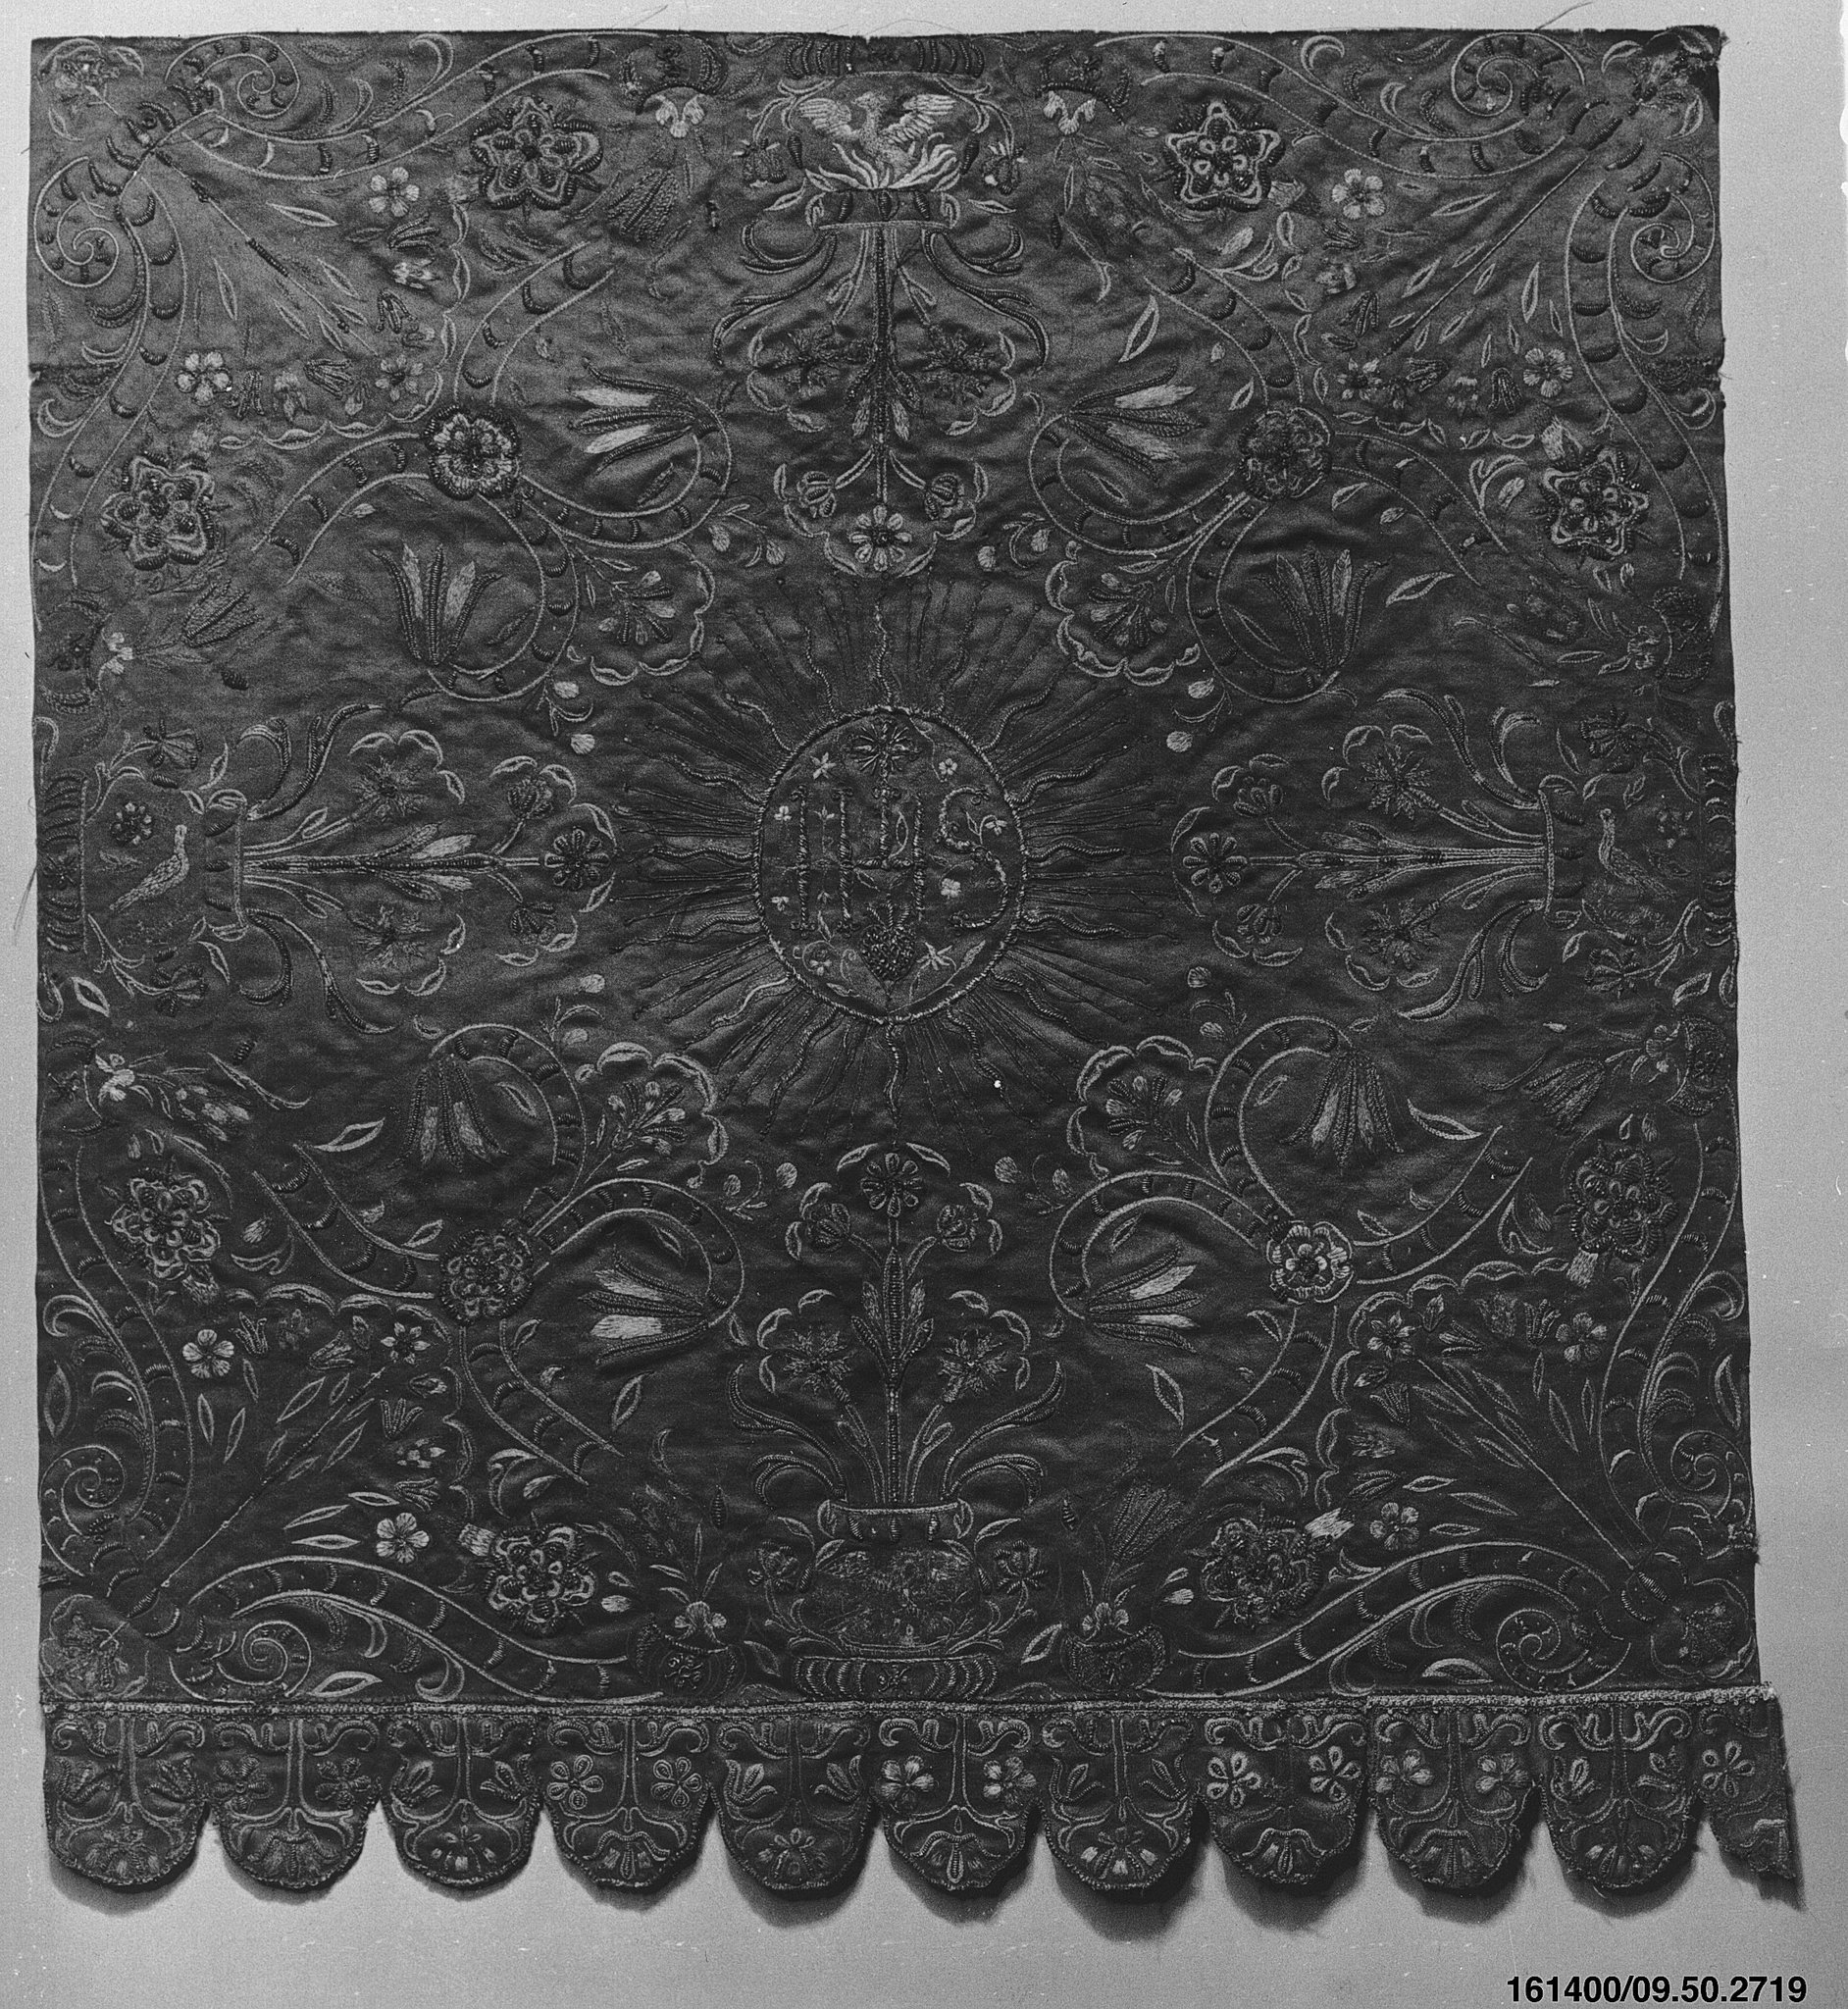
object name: panel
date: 1601-1800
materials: metal, silk